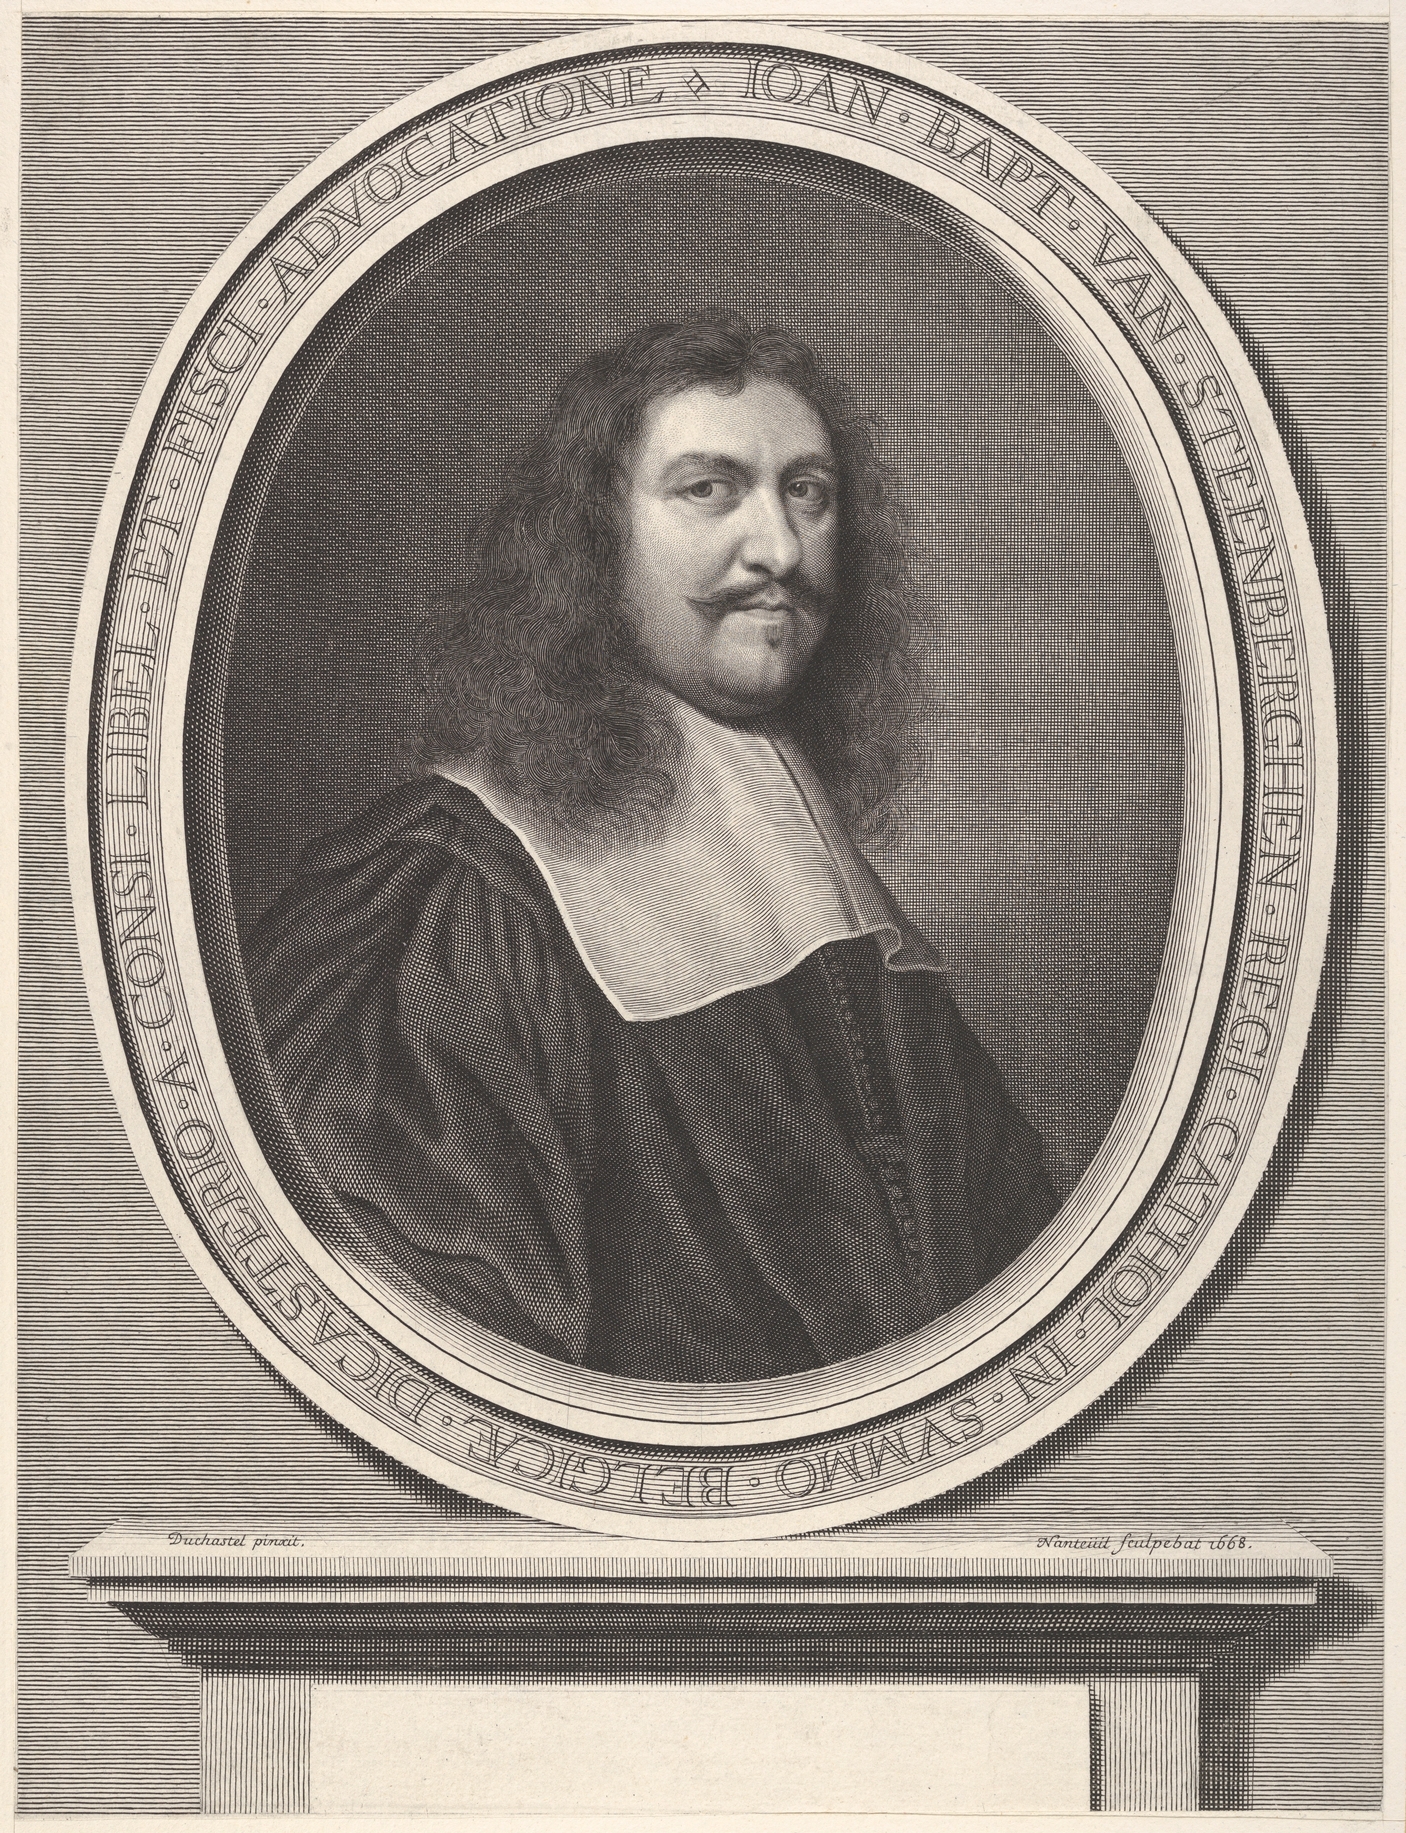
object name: print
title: Jean-Baptiste van Steenberghen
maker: robert nanteuil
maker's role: artist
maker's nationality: french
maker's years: 1623-1678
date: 1668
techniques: engraving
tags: men,portraits